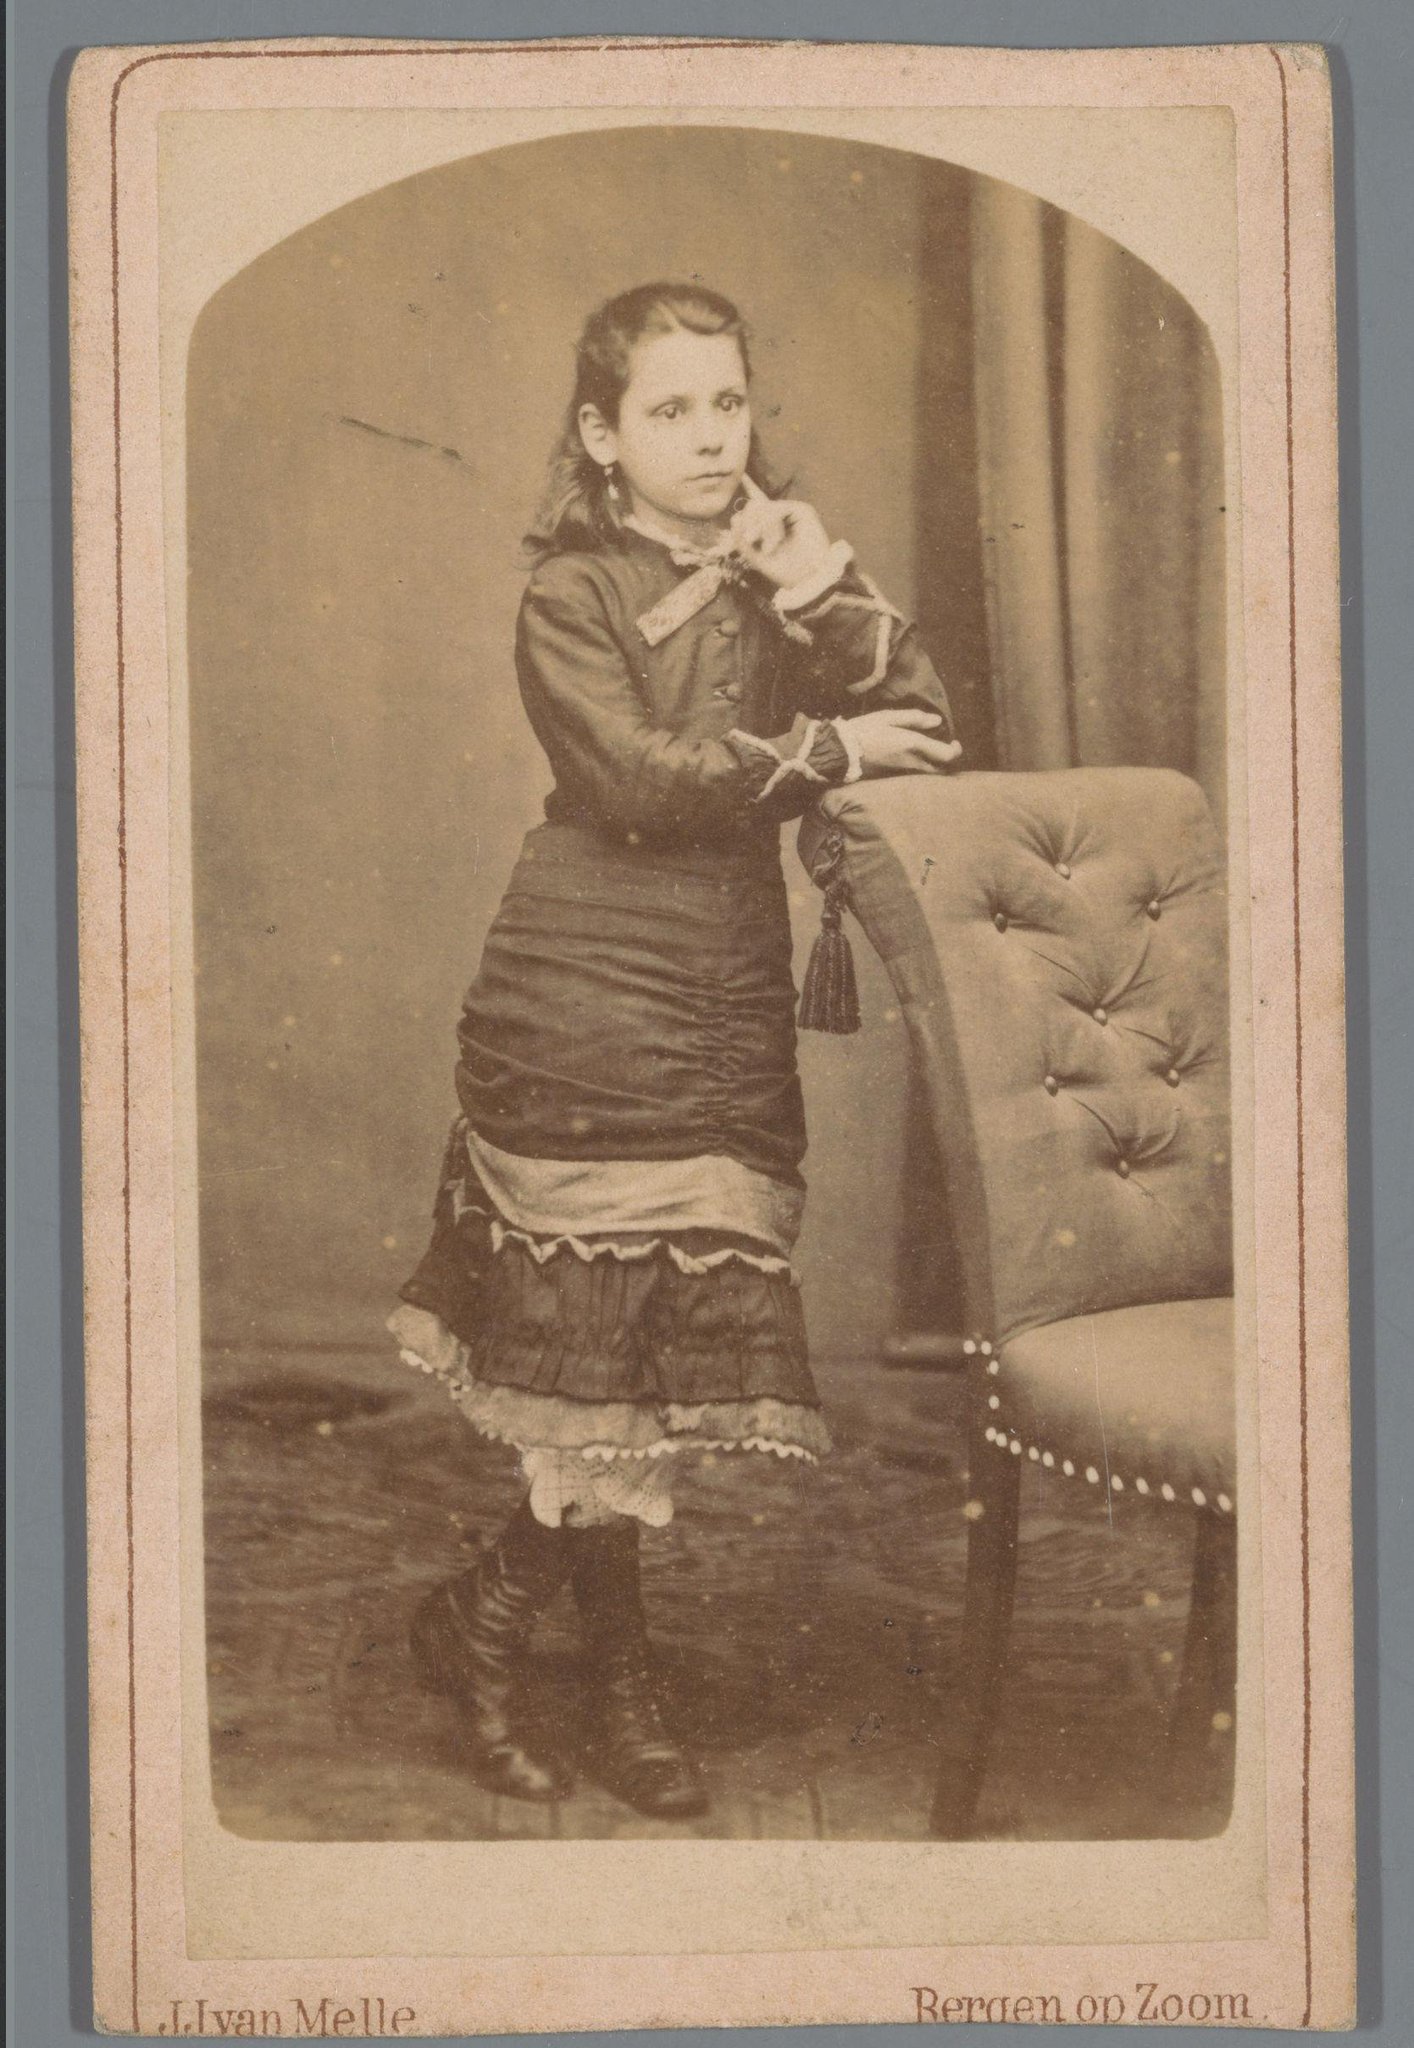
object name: photograph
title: Portret van een onbekend meisje achter een stoel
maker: jannis jacobus van melle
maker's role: fotograaf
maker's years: 1829-1911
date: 1877-1885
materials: cardboard, paper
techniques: albumen print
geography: bergen op zoom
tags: girl (child between toddler and youth), anonymous historical person portrayed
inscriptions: inscription: ‘De plaat blyft voor nabestelling bewaard.’, address: ‘BERGEN/ OP/ ZOOM./ Rijkebuurtstraat.’